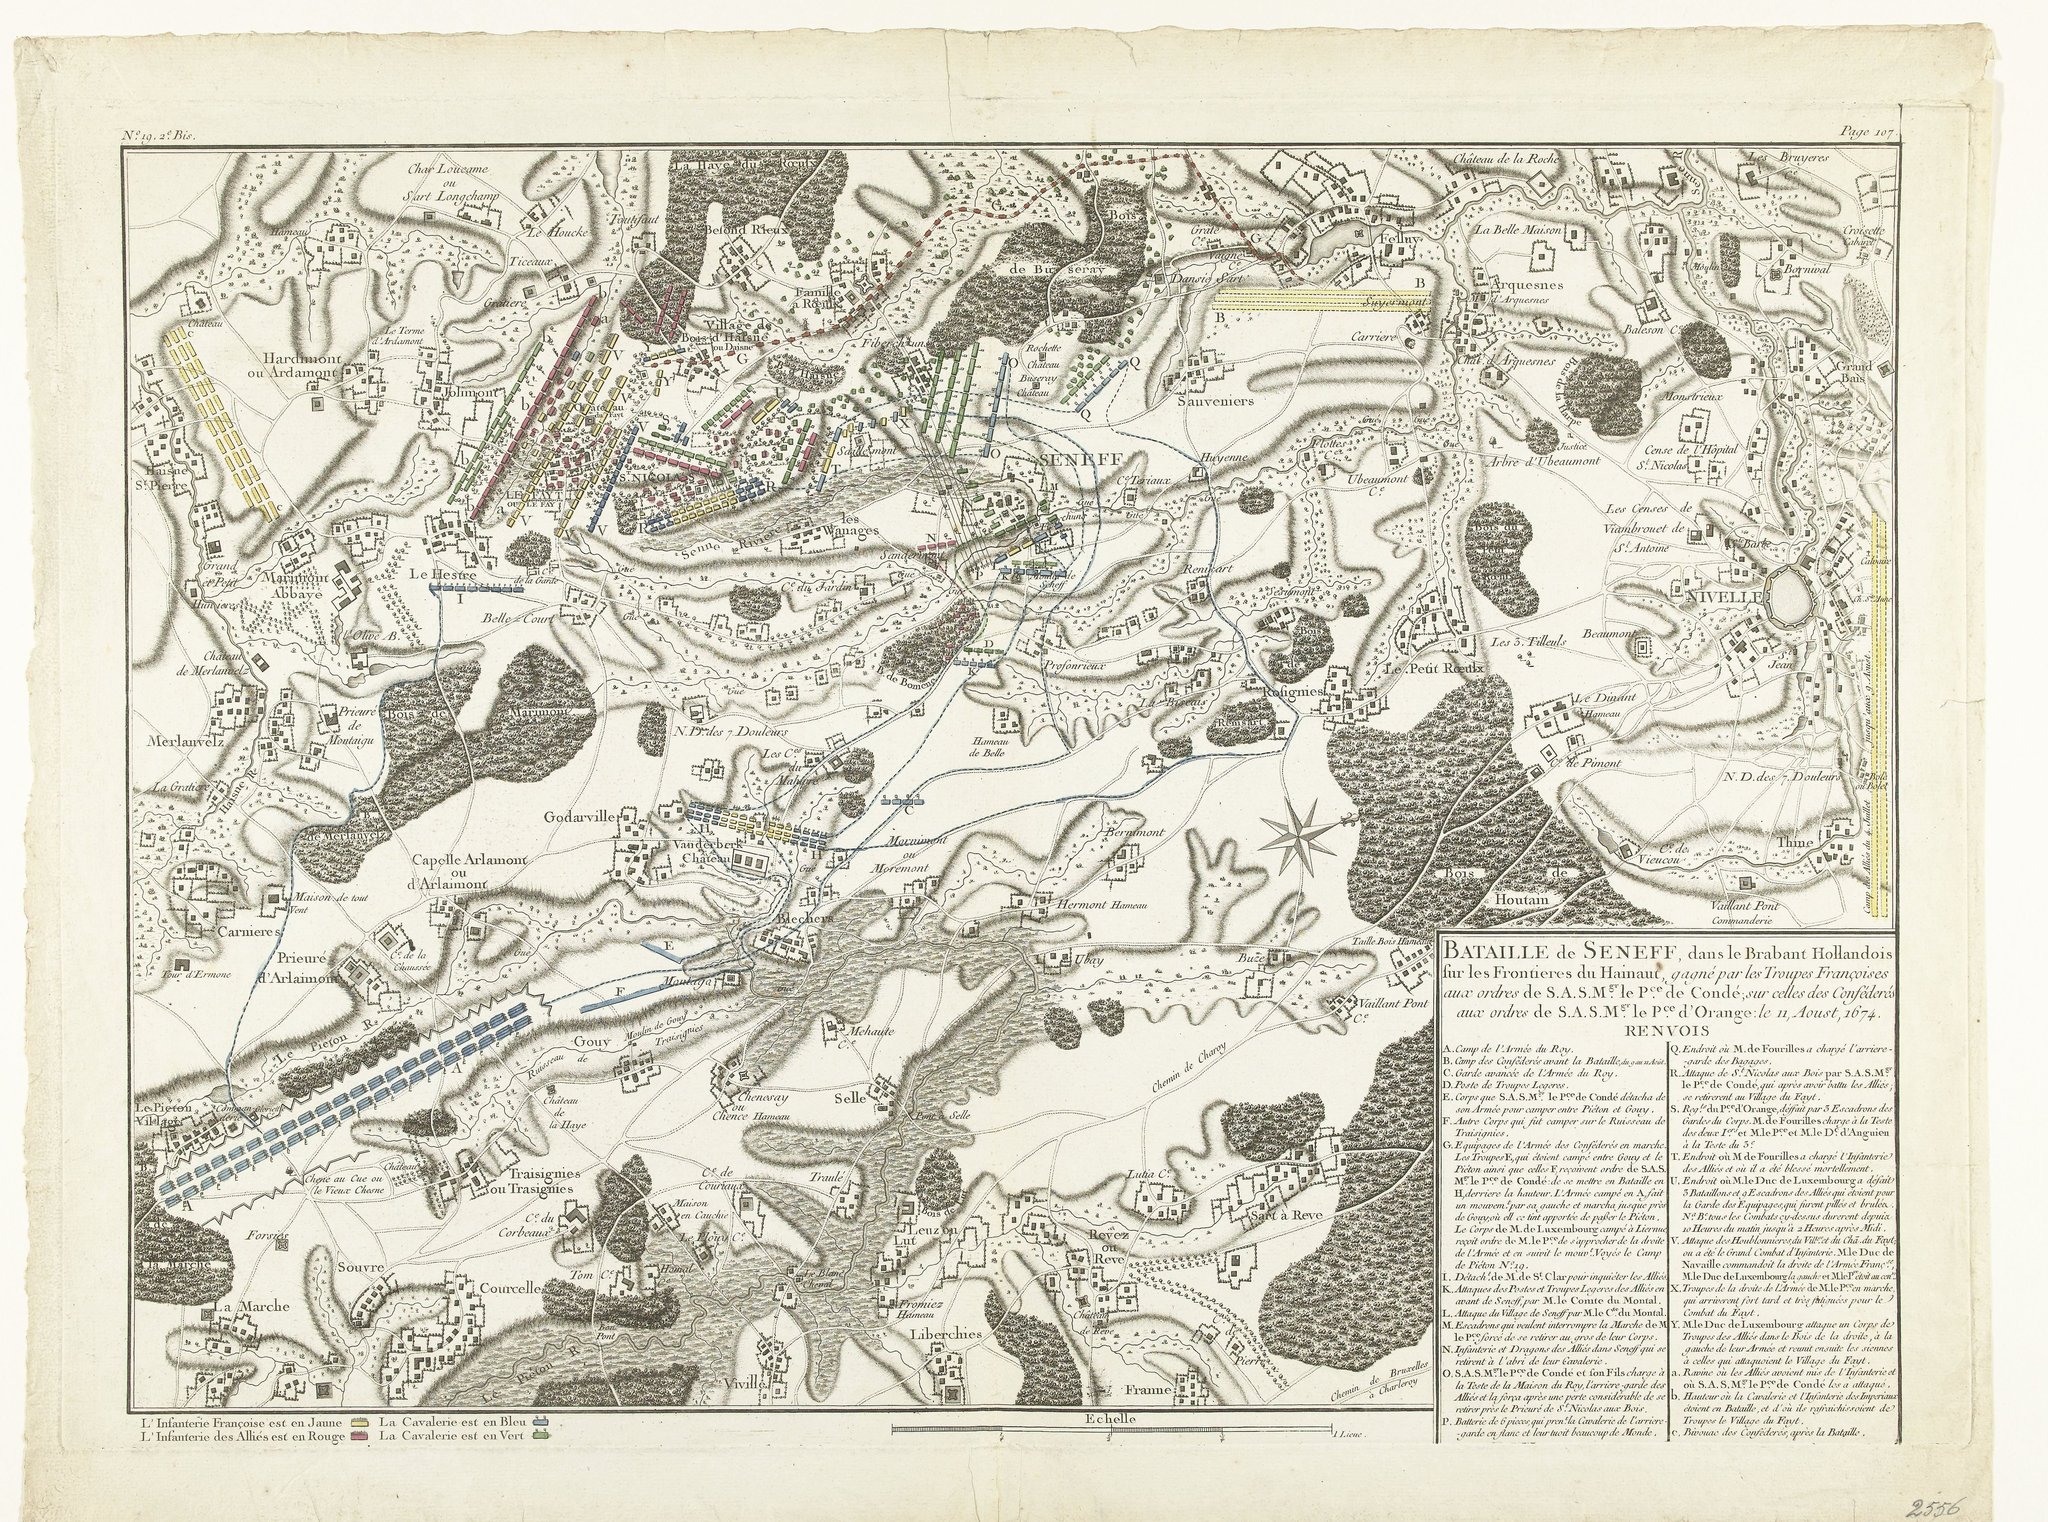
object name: map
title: Kaart van de slag bij Seneffe, 1674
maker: Anonymous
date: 1675-1724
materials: paper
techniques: etching, hand coloring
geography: france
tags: the hague, william iii (prince of orange and king of england, scotland, and ireland), paris, lodewijk ii de bourbon-condé (hertog van enghien), maps of separate countries or regions, battle (+ land forces)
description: Kaart van het gebied tussen Seneffe en Nivelles waar de slag bij Seneffe is uitgevochten op 11 augustus 1674 tussen een Frans leger onder maarschalk Condé en een Nederlands-Spaans-Oostenrijks-Duits leger (de geallieerden) onder stadhouder Willem III. Rechtsonder de legenda A-c in het Frans. Gemerkt bovenaan links: No. 19, 2e Bis. Gemerkt bovenaan rechts: Page 107.